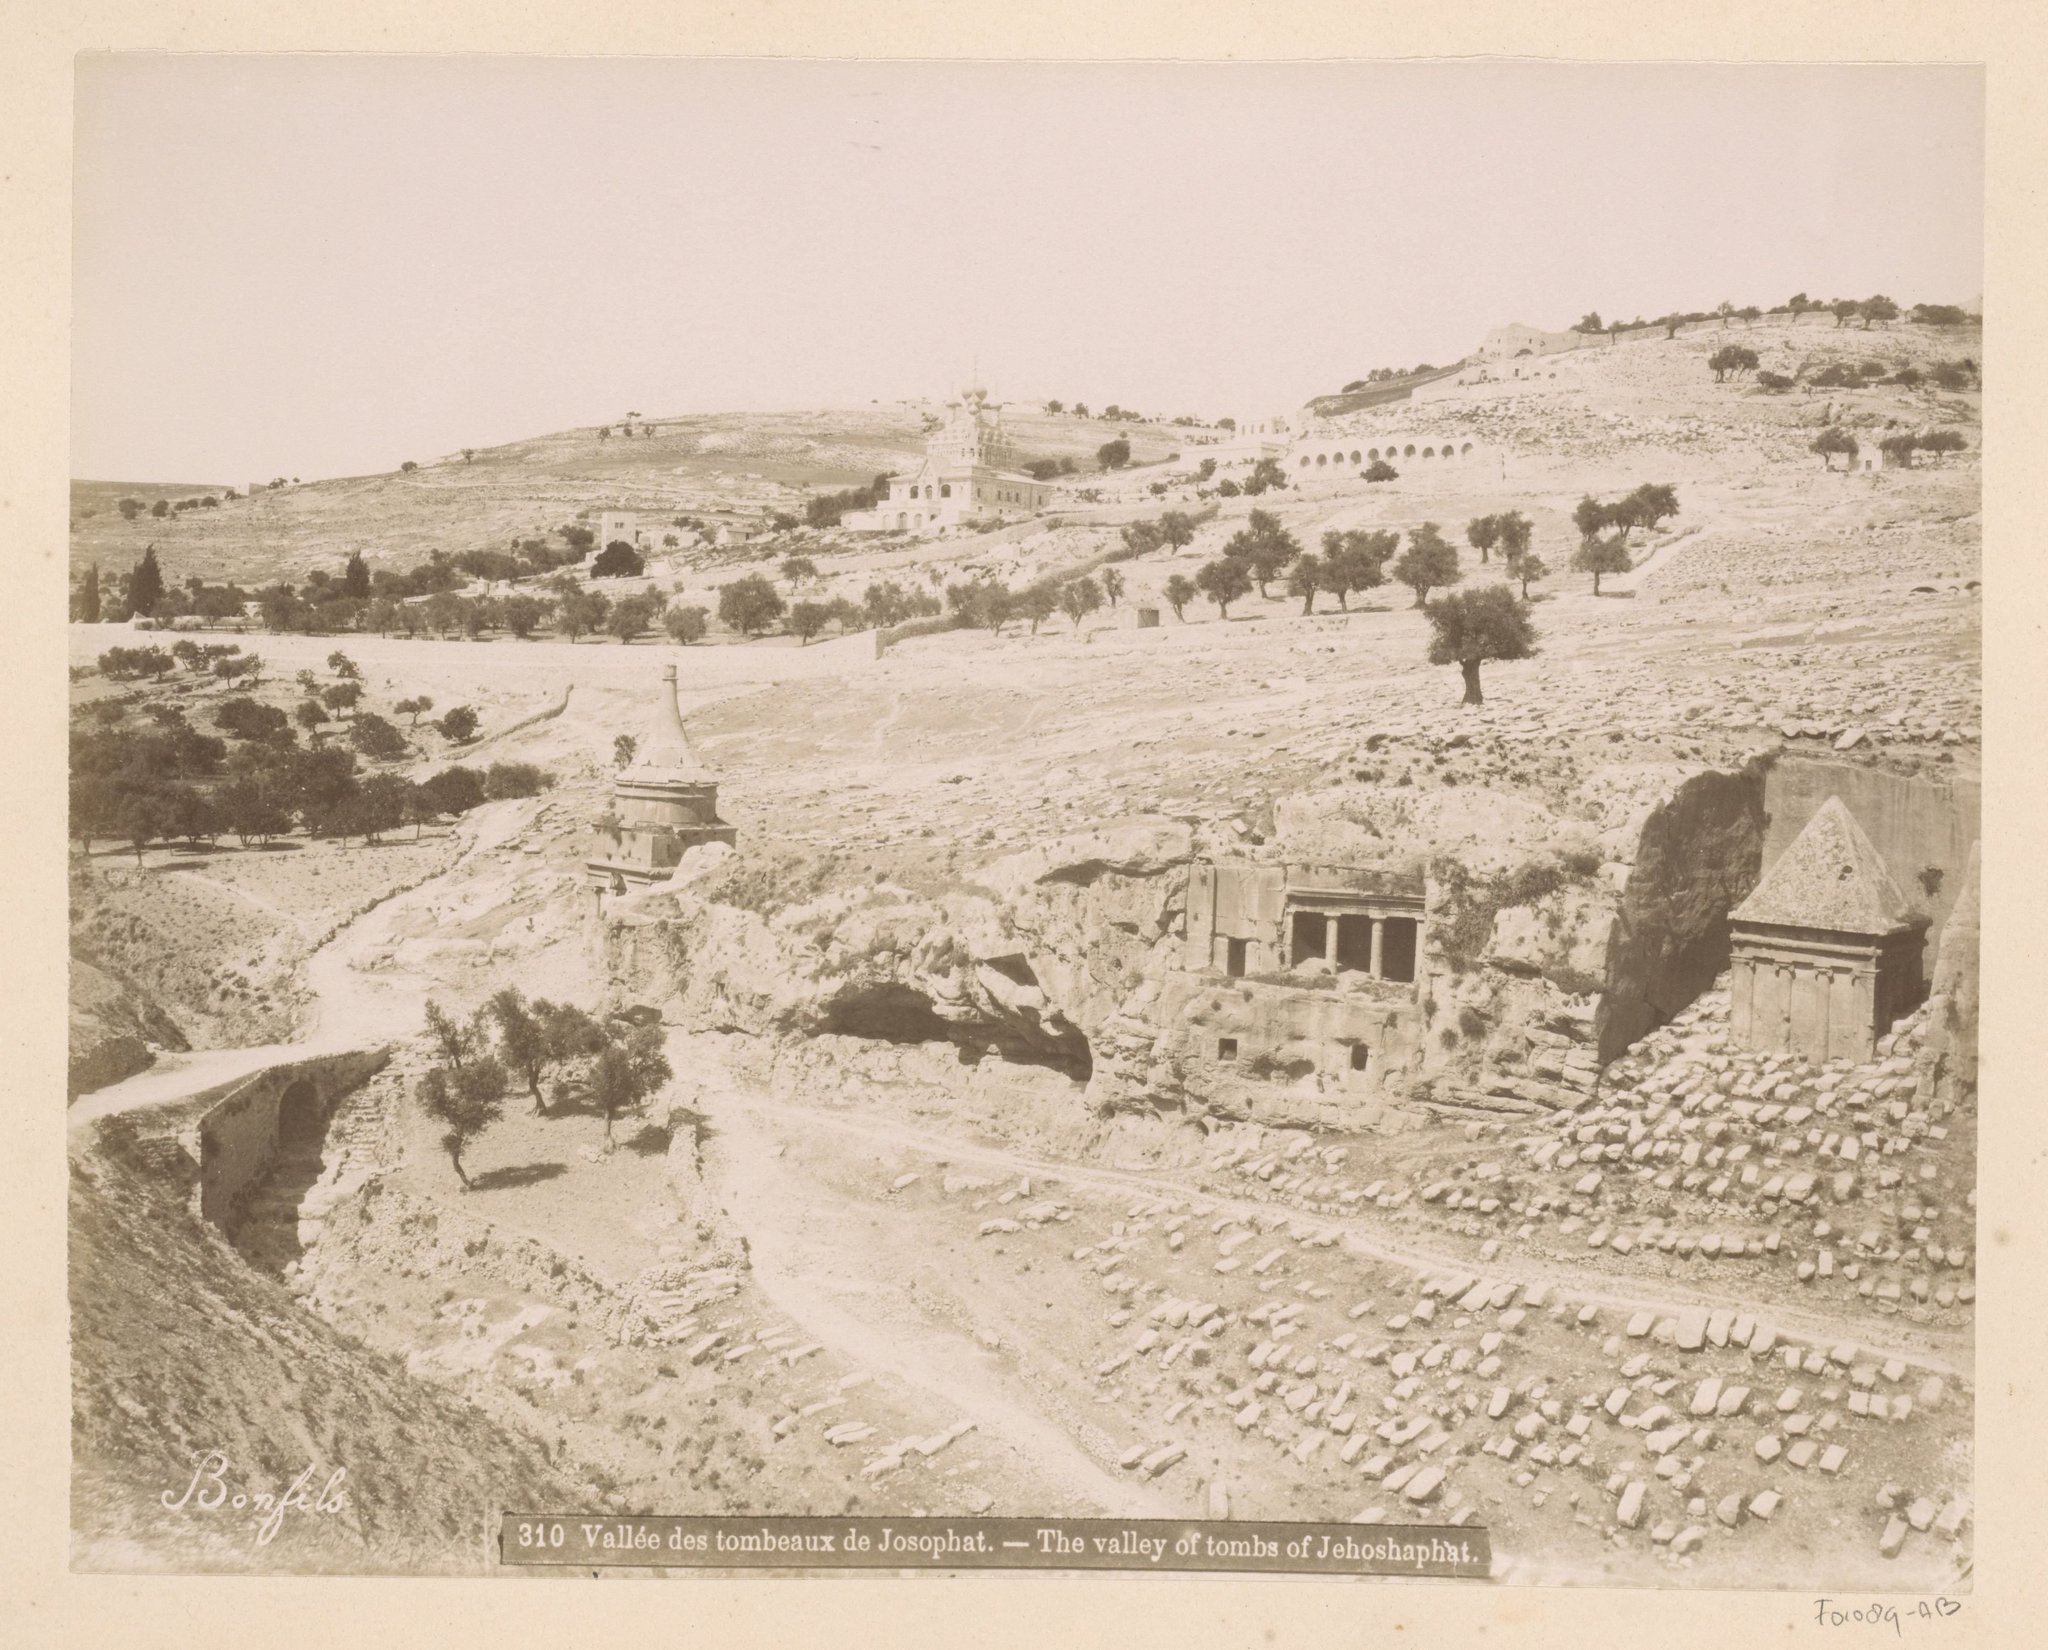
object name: photograph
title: Vallée des tombeaux de Josophat.- The valley of tombs of Jehoshaphat.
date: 1867-1895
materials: cardboard, paper, photographic support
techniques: albumen print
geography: jerusalem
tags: dale, valley, grave, tomb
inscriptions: negative number: ‘310’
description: Onderdeel van Reisalbum met foto's van Jeruzalem en andere bijbelse plaatsen.